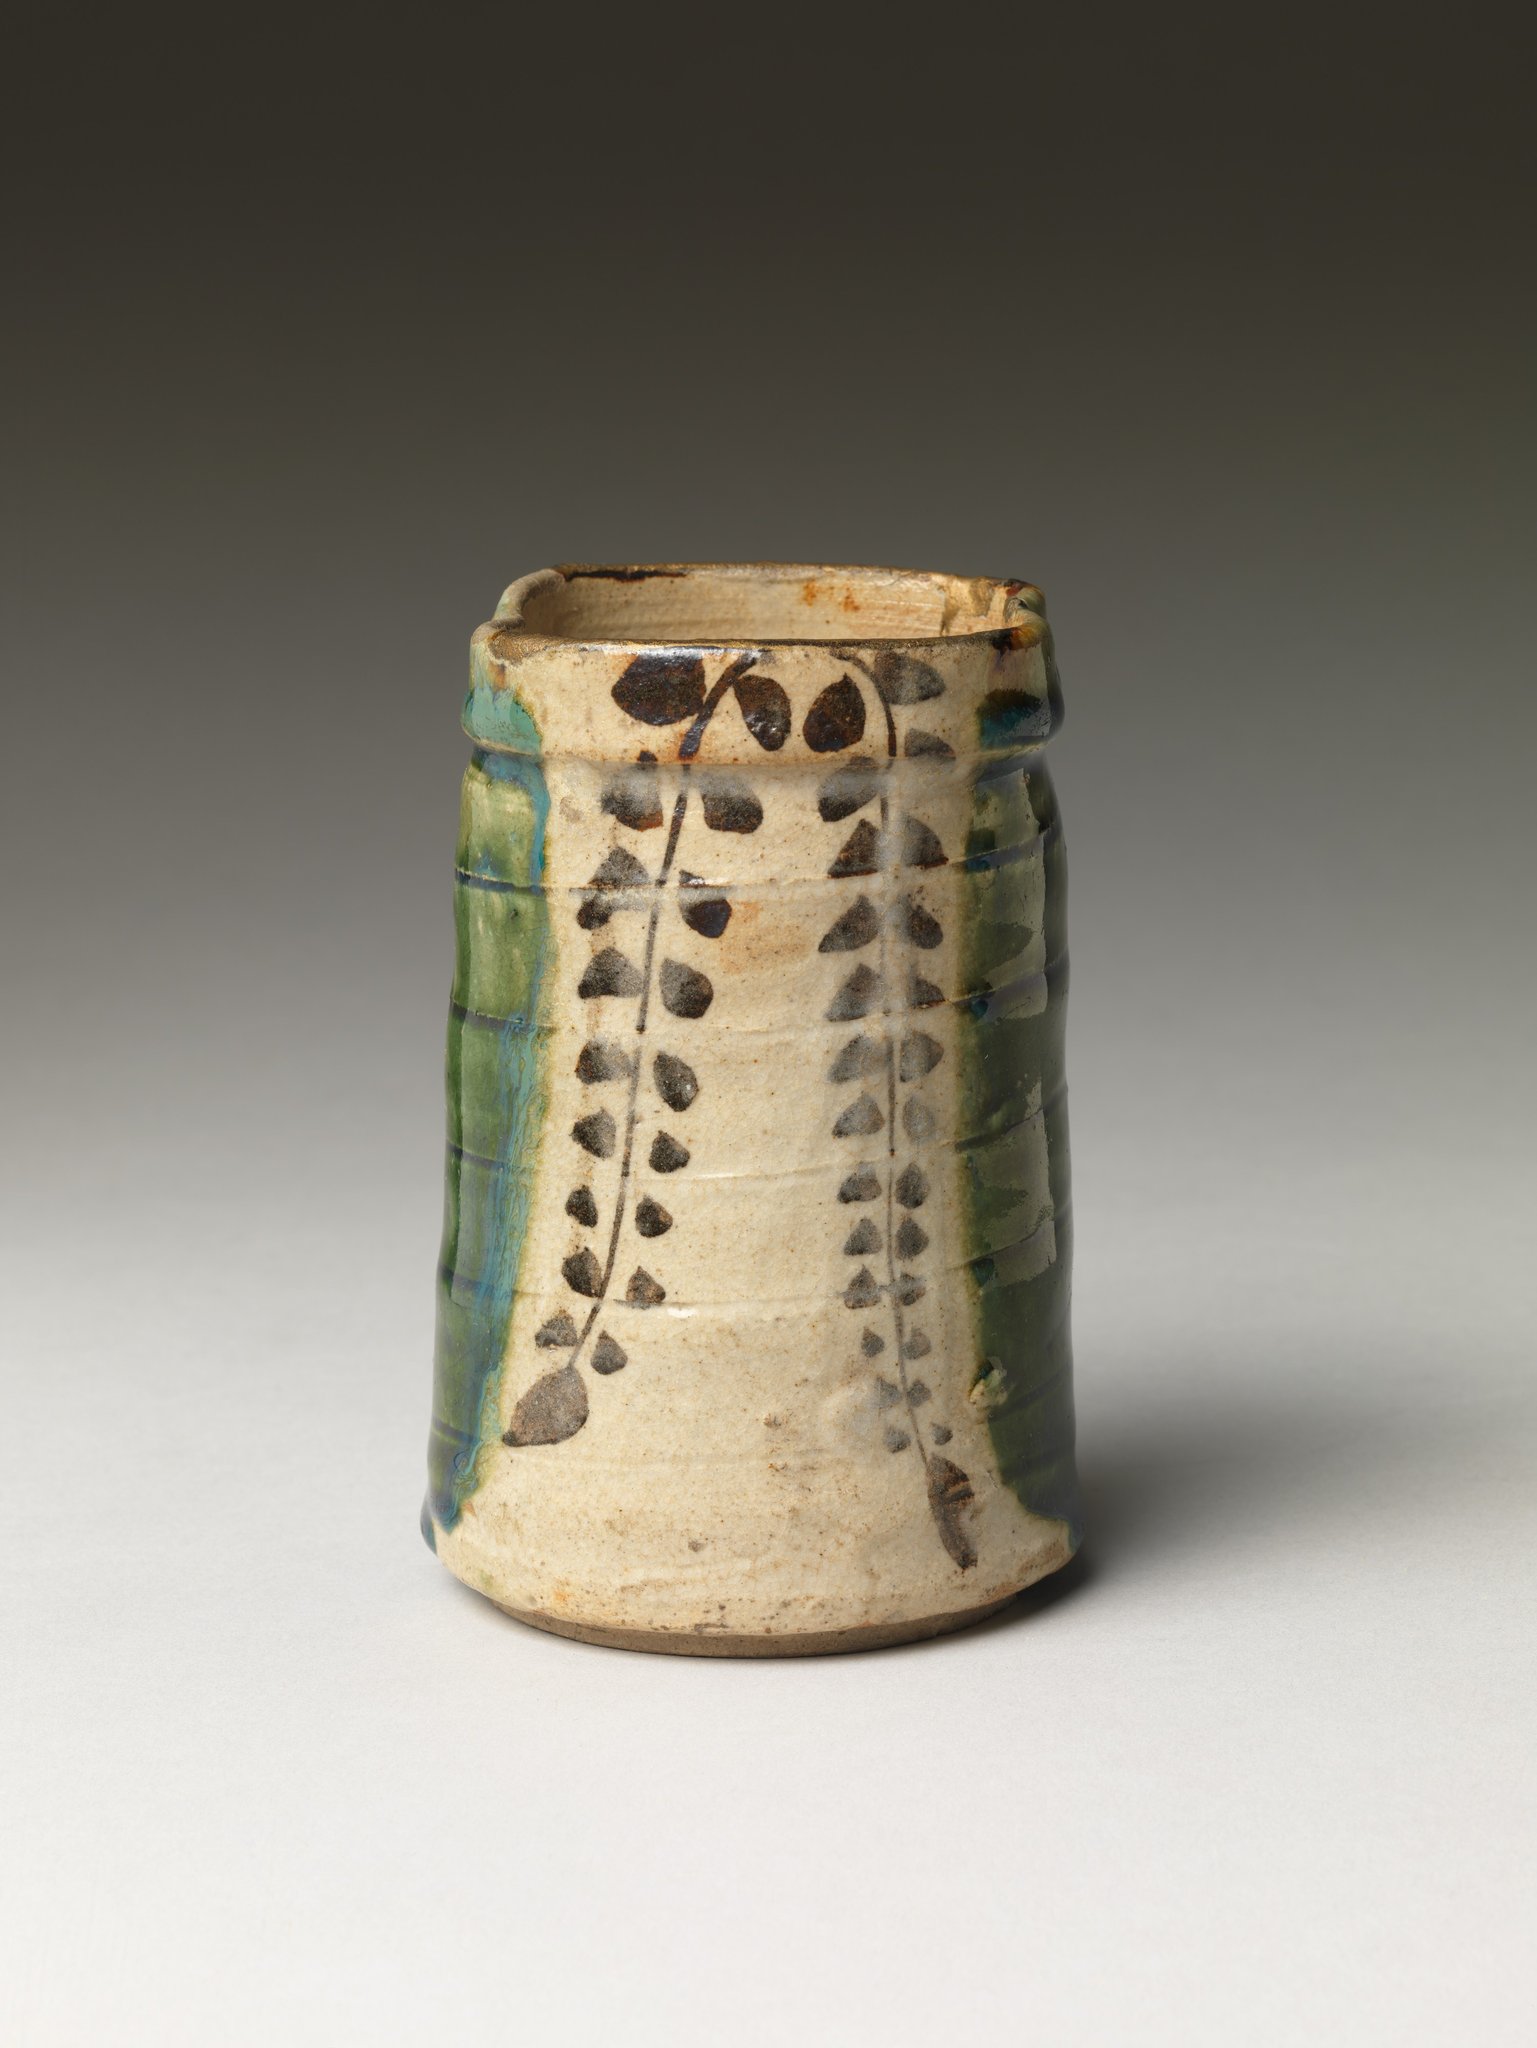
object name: dish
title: Side Dish (Mukōzuke) with Wisteria Design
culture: japanese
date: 1801-1850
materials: copper, glaze, iron, stoneware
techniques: underglaze